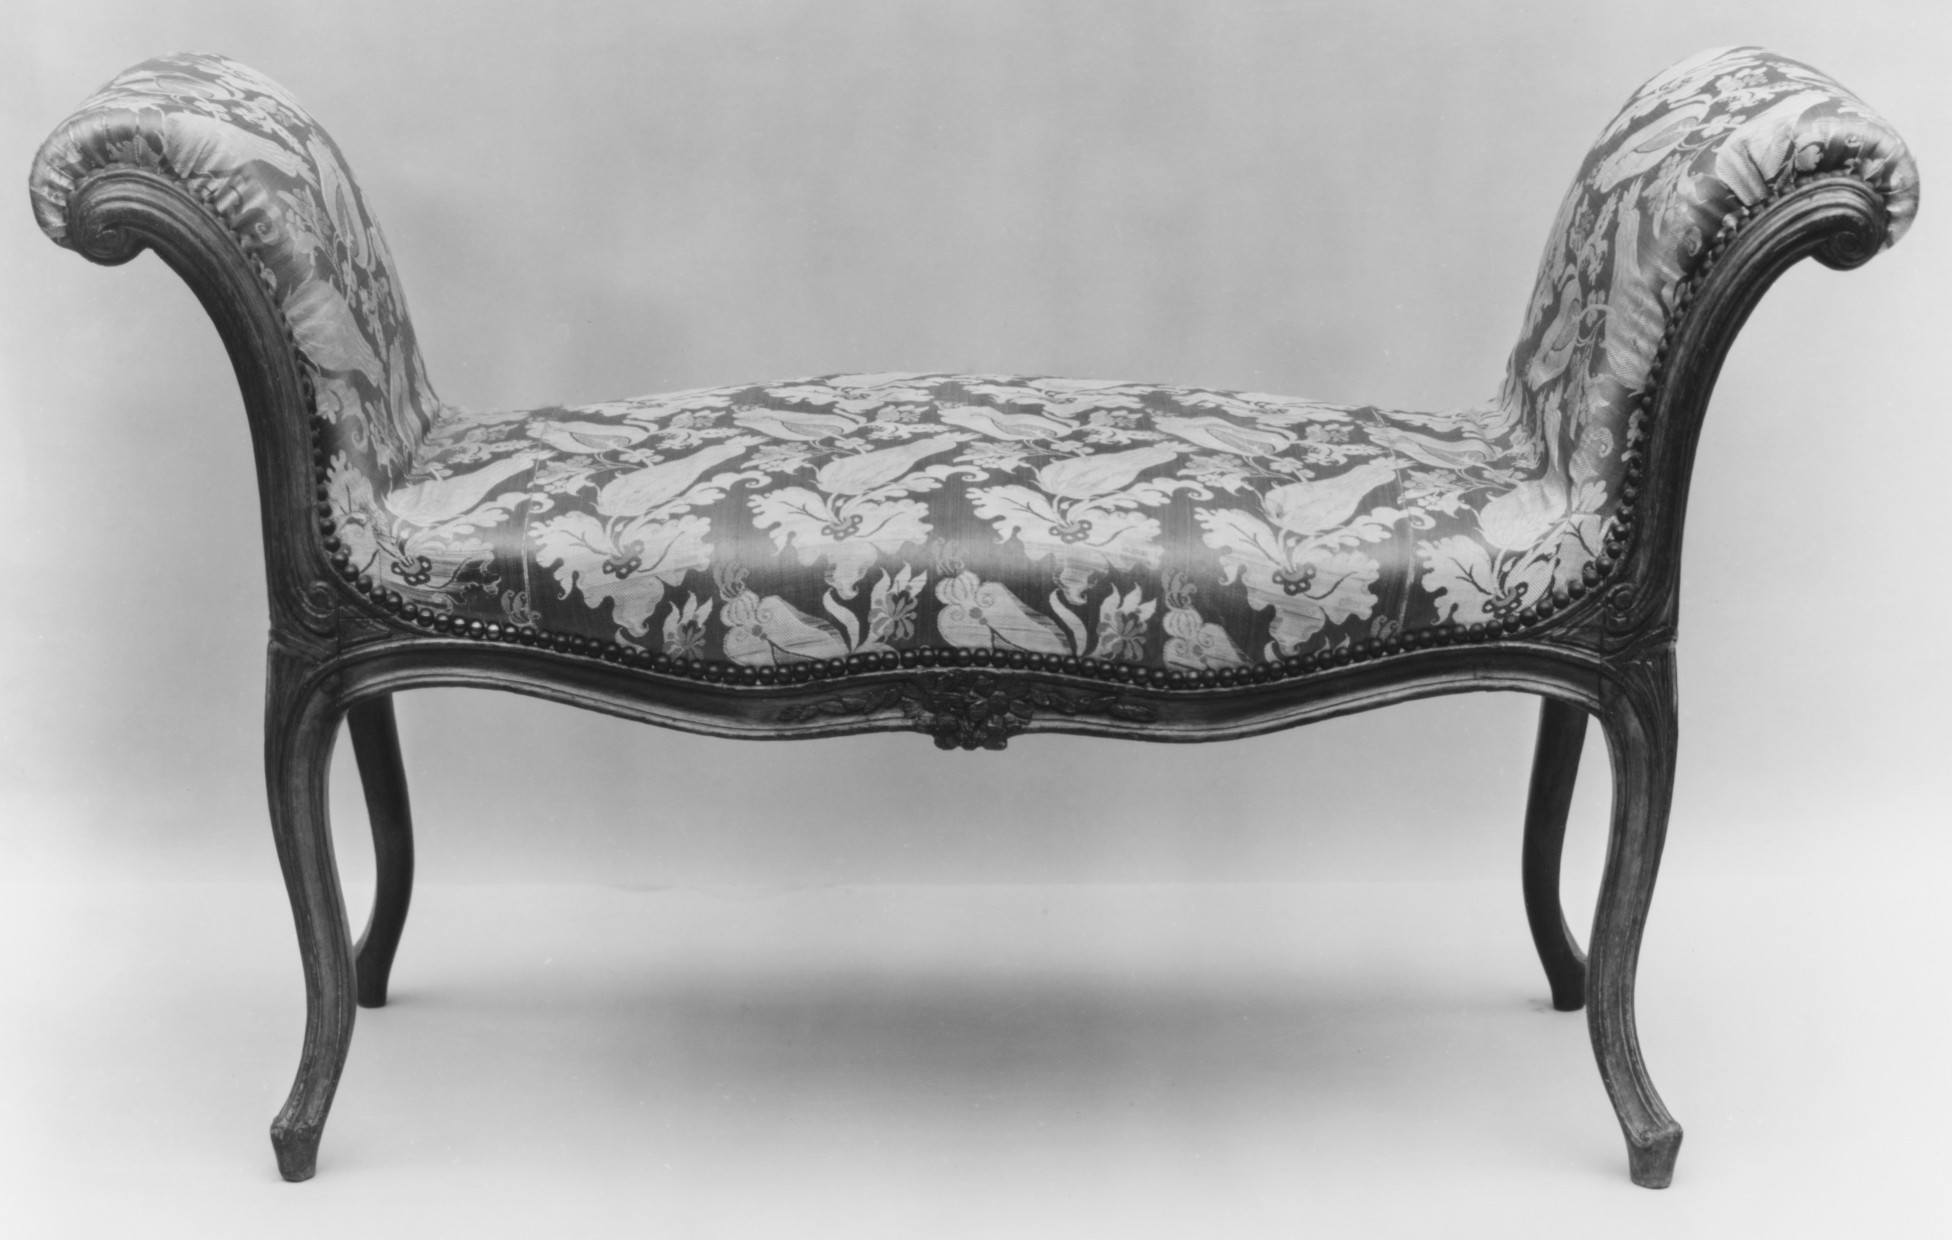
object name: window seat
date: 1734-1766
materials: wood, silk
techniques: carving